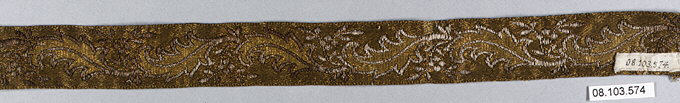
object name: galloon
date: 1701-1800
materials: metal thread